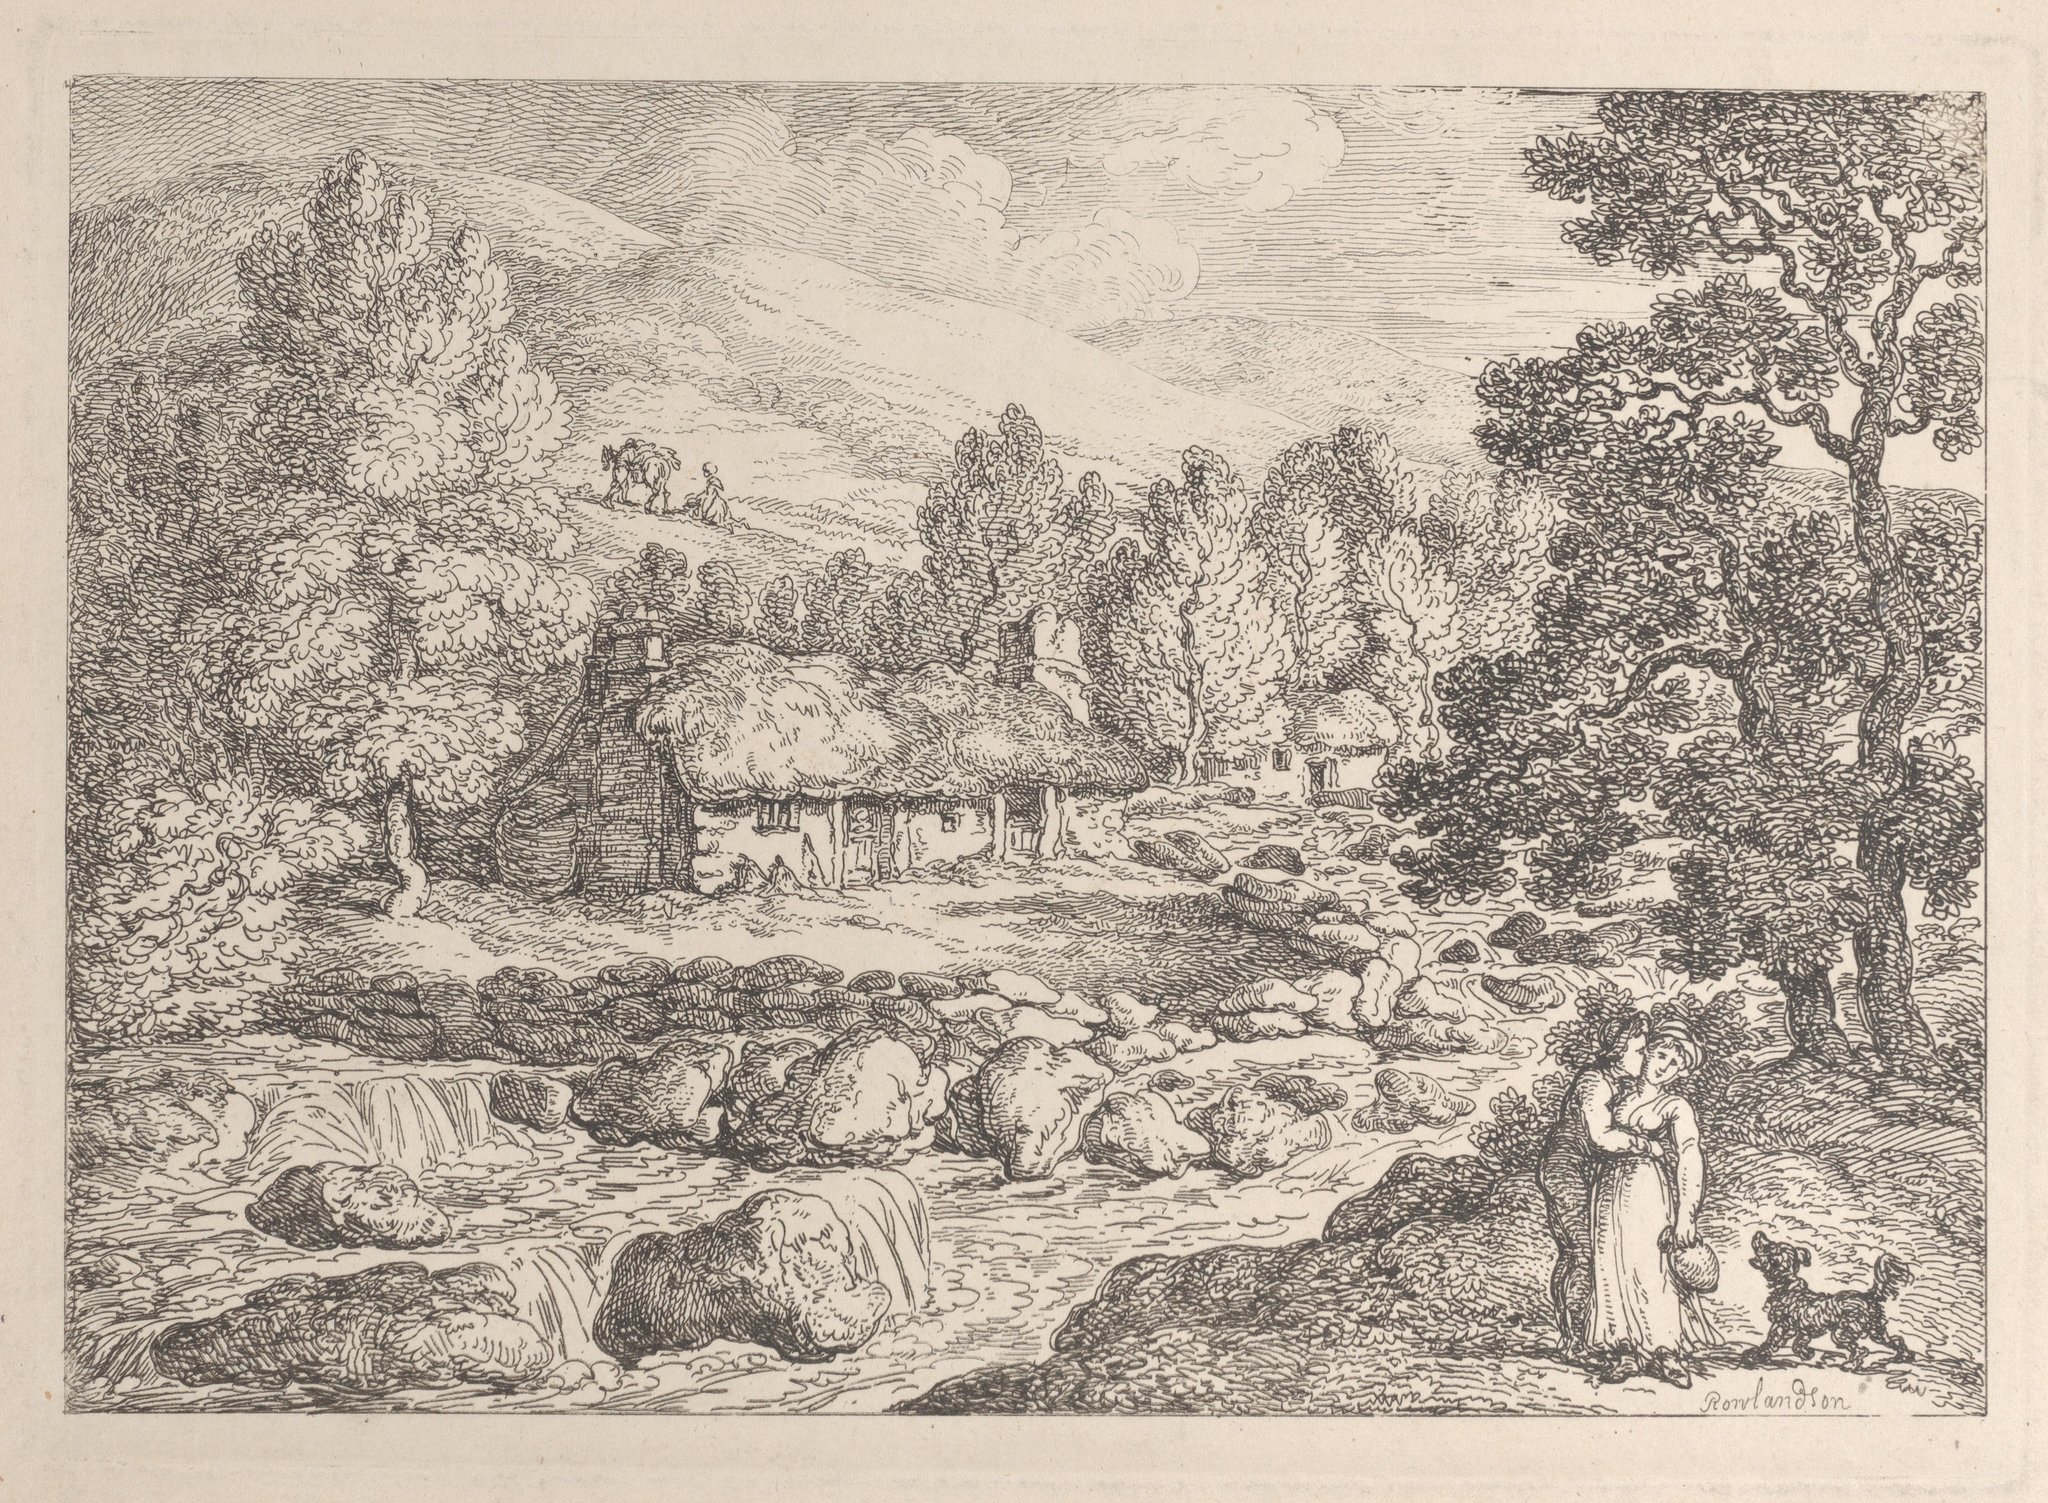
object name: print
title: A Cornish Waterfall, from "Views in Cornwall"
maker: thomas rowlandson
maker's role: artist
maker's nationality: british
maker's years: 1757-1827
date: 1812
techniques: etching